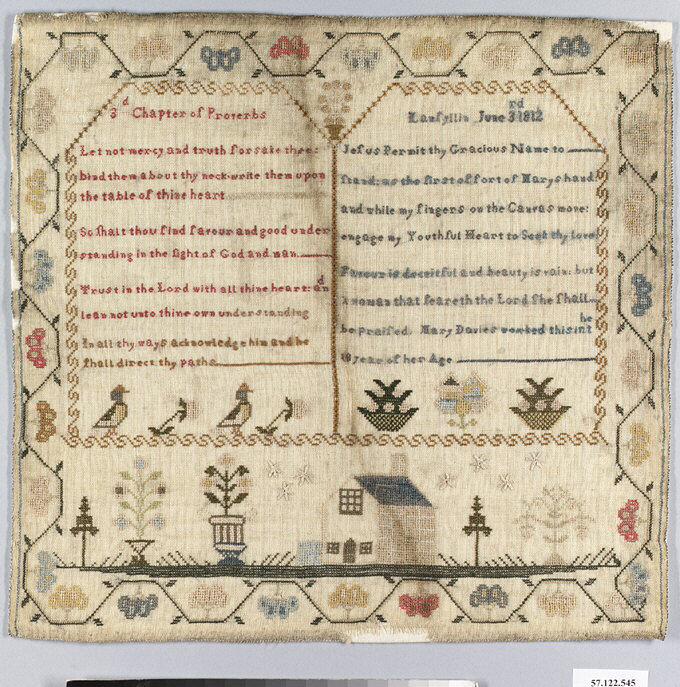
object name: sampler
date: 1812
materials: canvas, wool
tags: birds,flowers